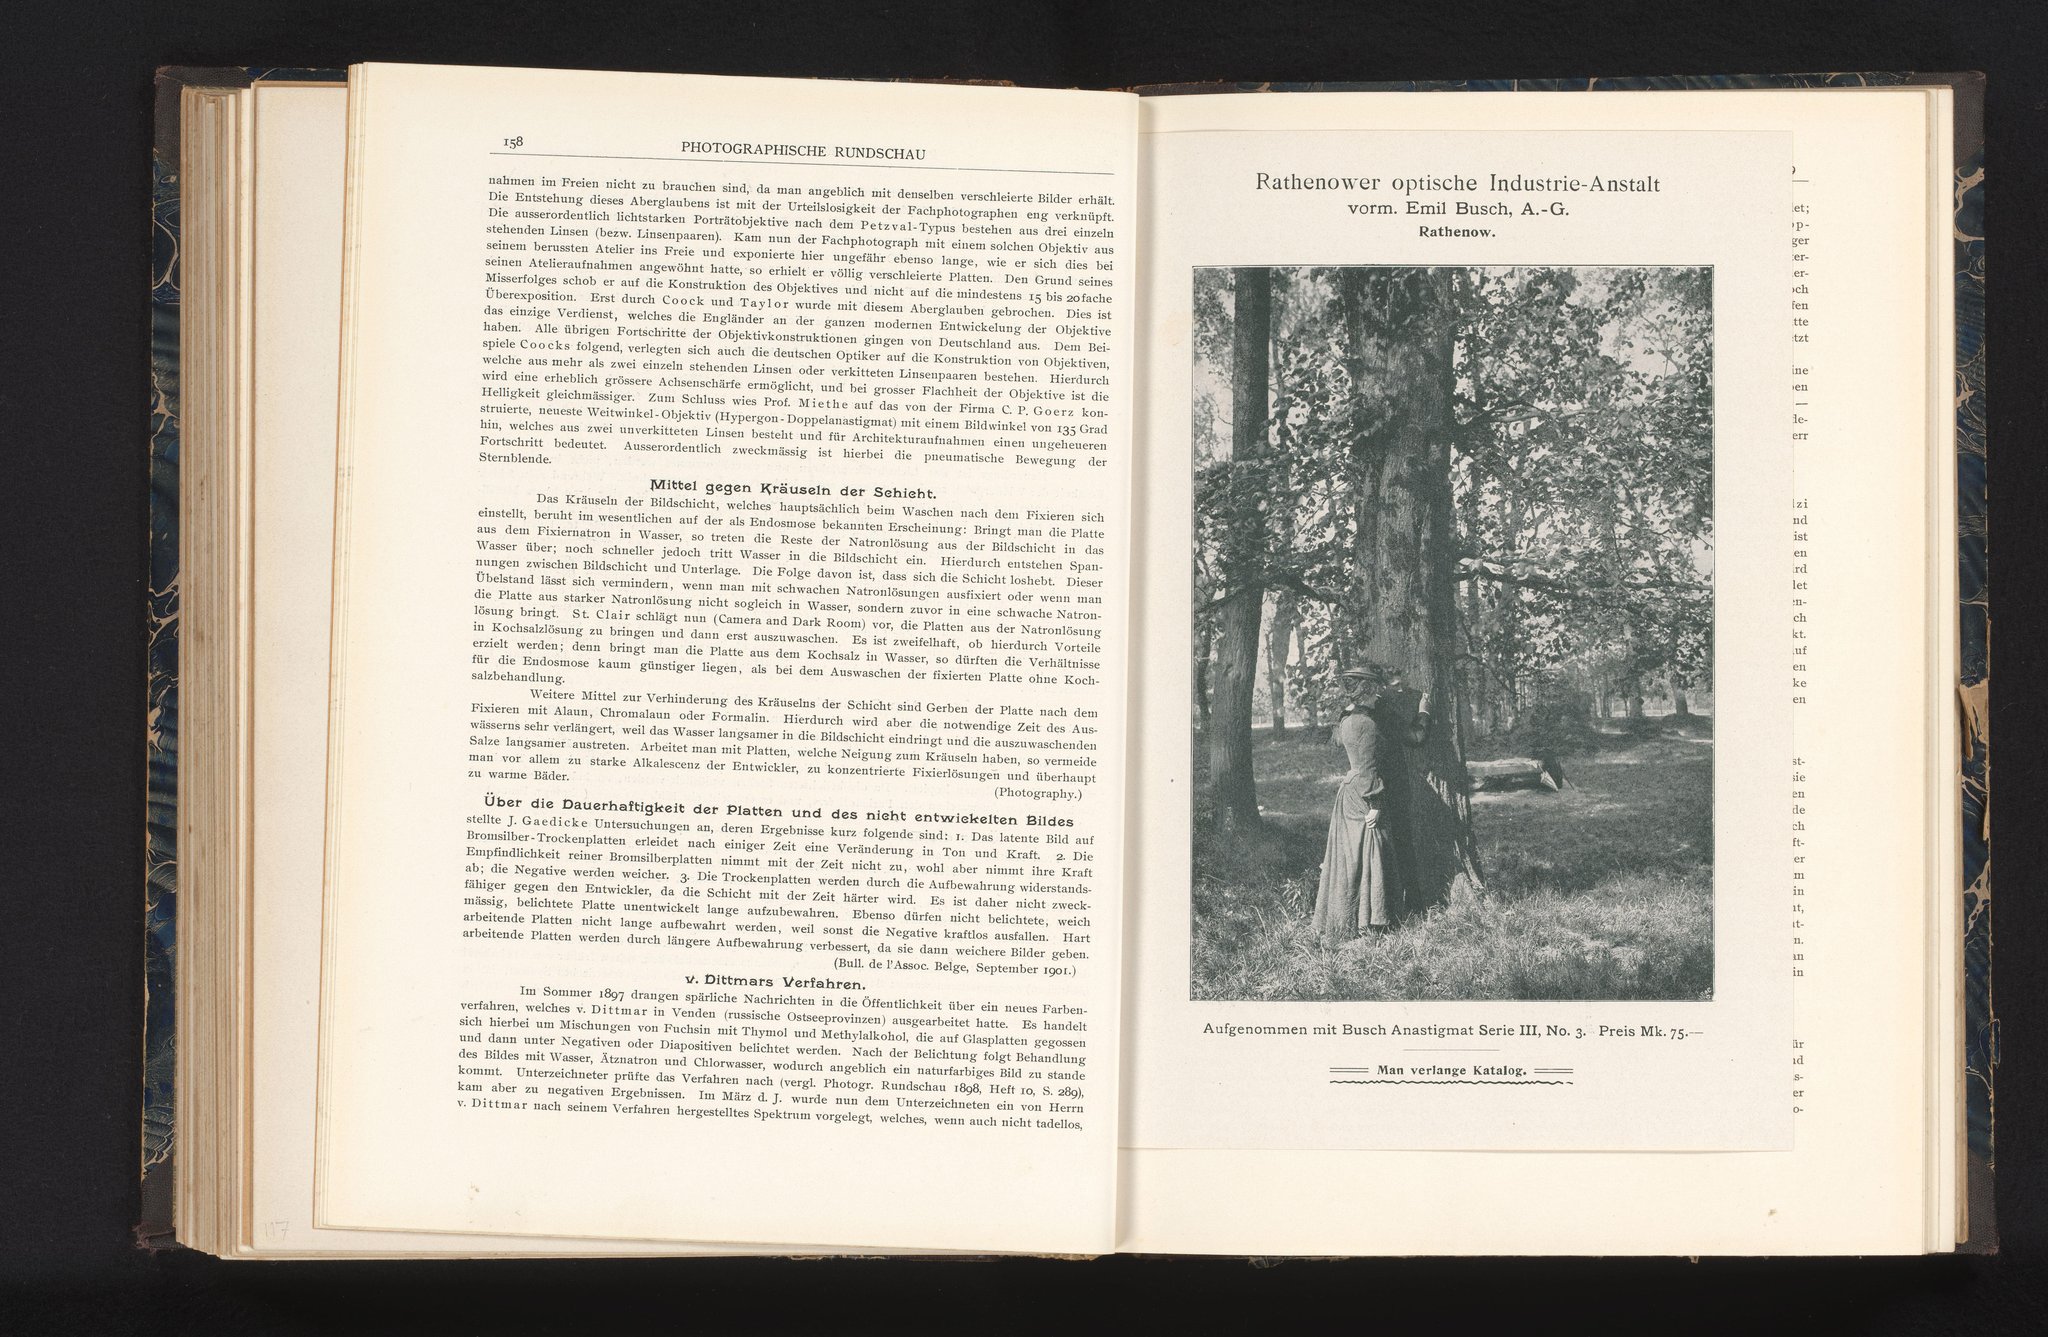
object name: photomechanical print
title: Gezicht op een onbekende man en een onbekende vrouw bij een boom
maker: Anonymous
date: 1897-1902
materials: paper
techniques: autotype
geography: berlin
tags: trees, adult woman, adult man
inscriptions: inscription: ‘Rathenower optische Industrie-Anstalt/ (...)’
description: Prent op pagina tussen pagina 158 en pagina 159.